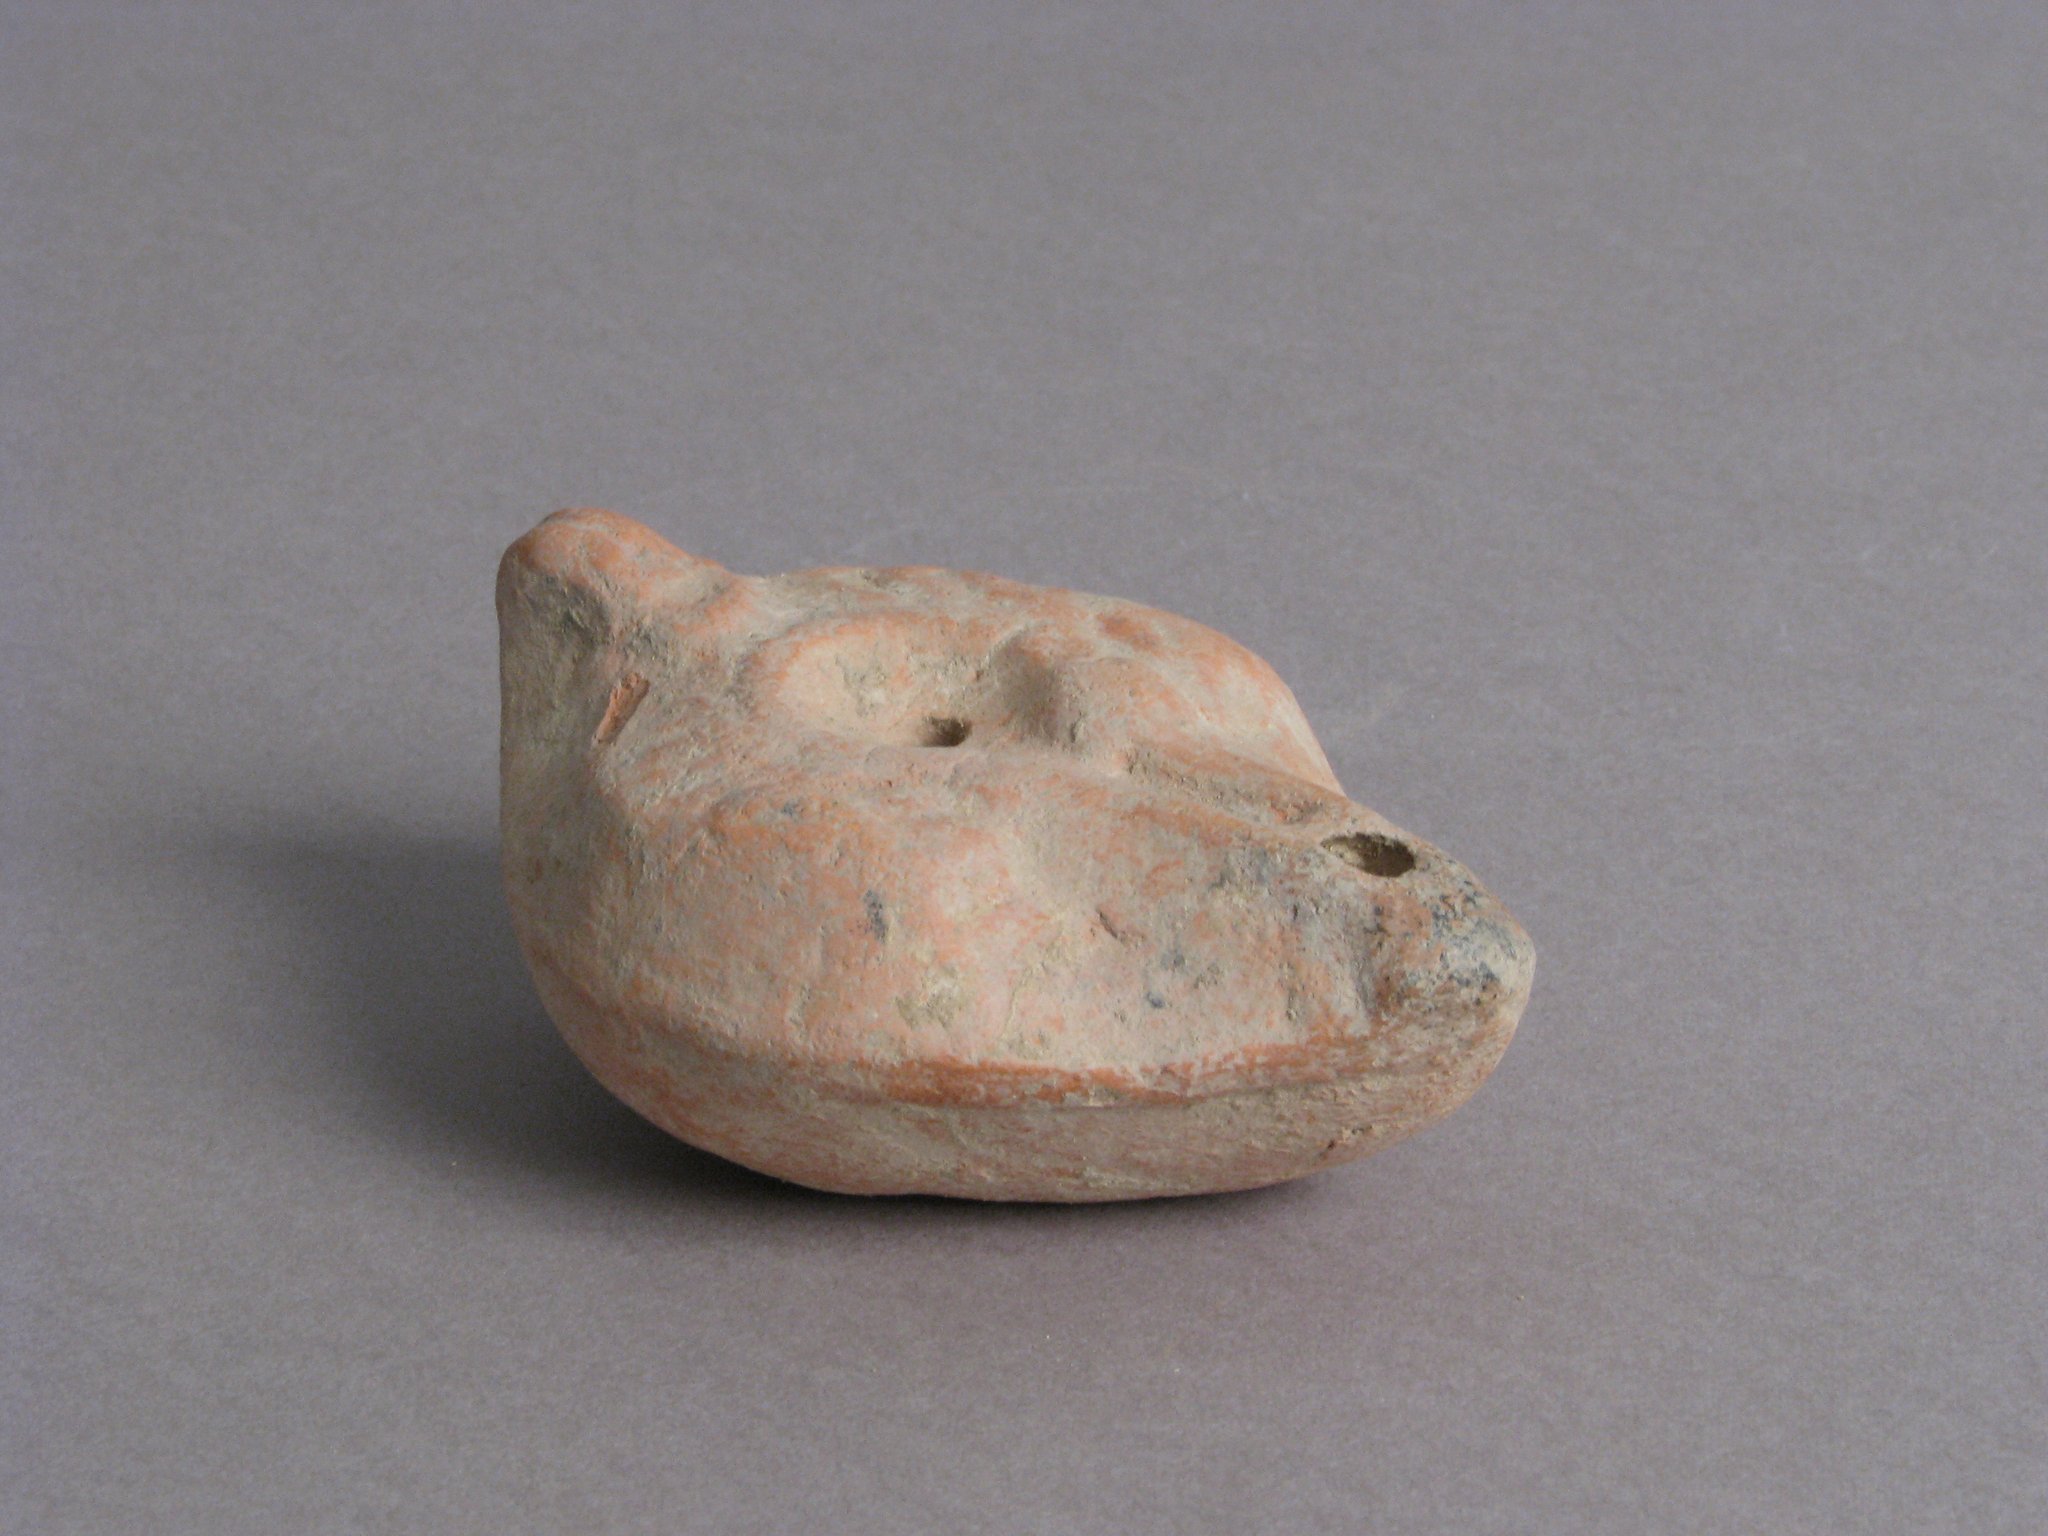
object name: lamp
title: Oil Lamp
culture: coptic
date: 301-700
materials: earthenware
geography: egypt